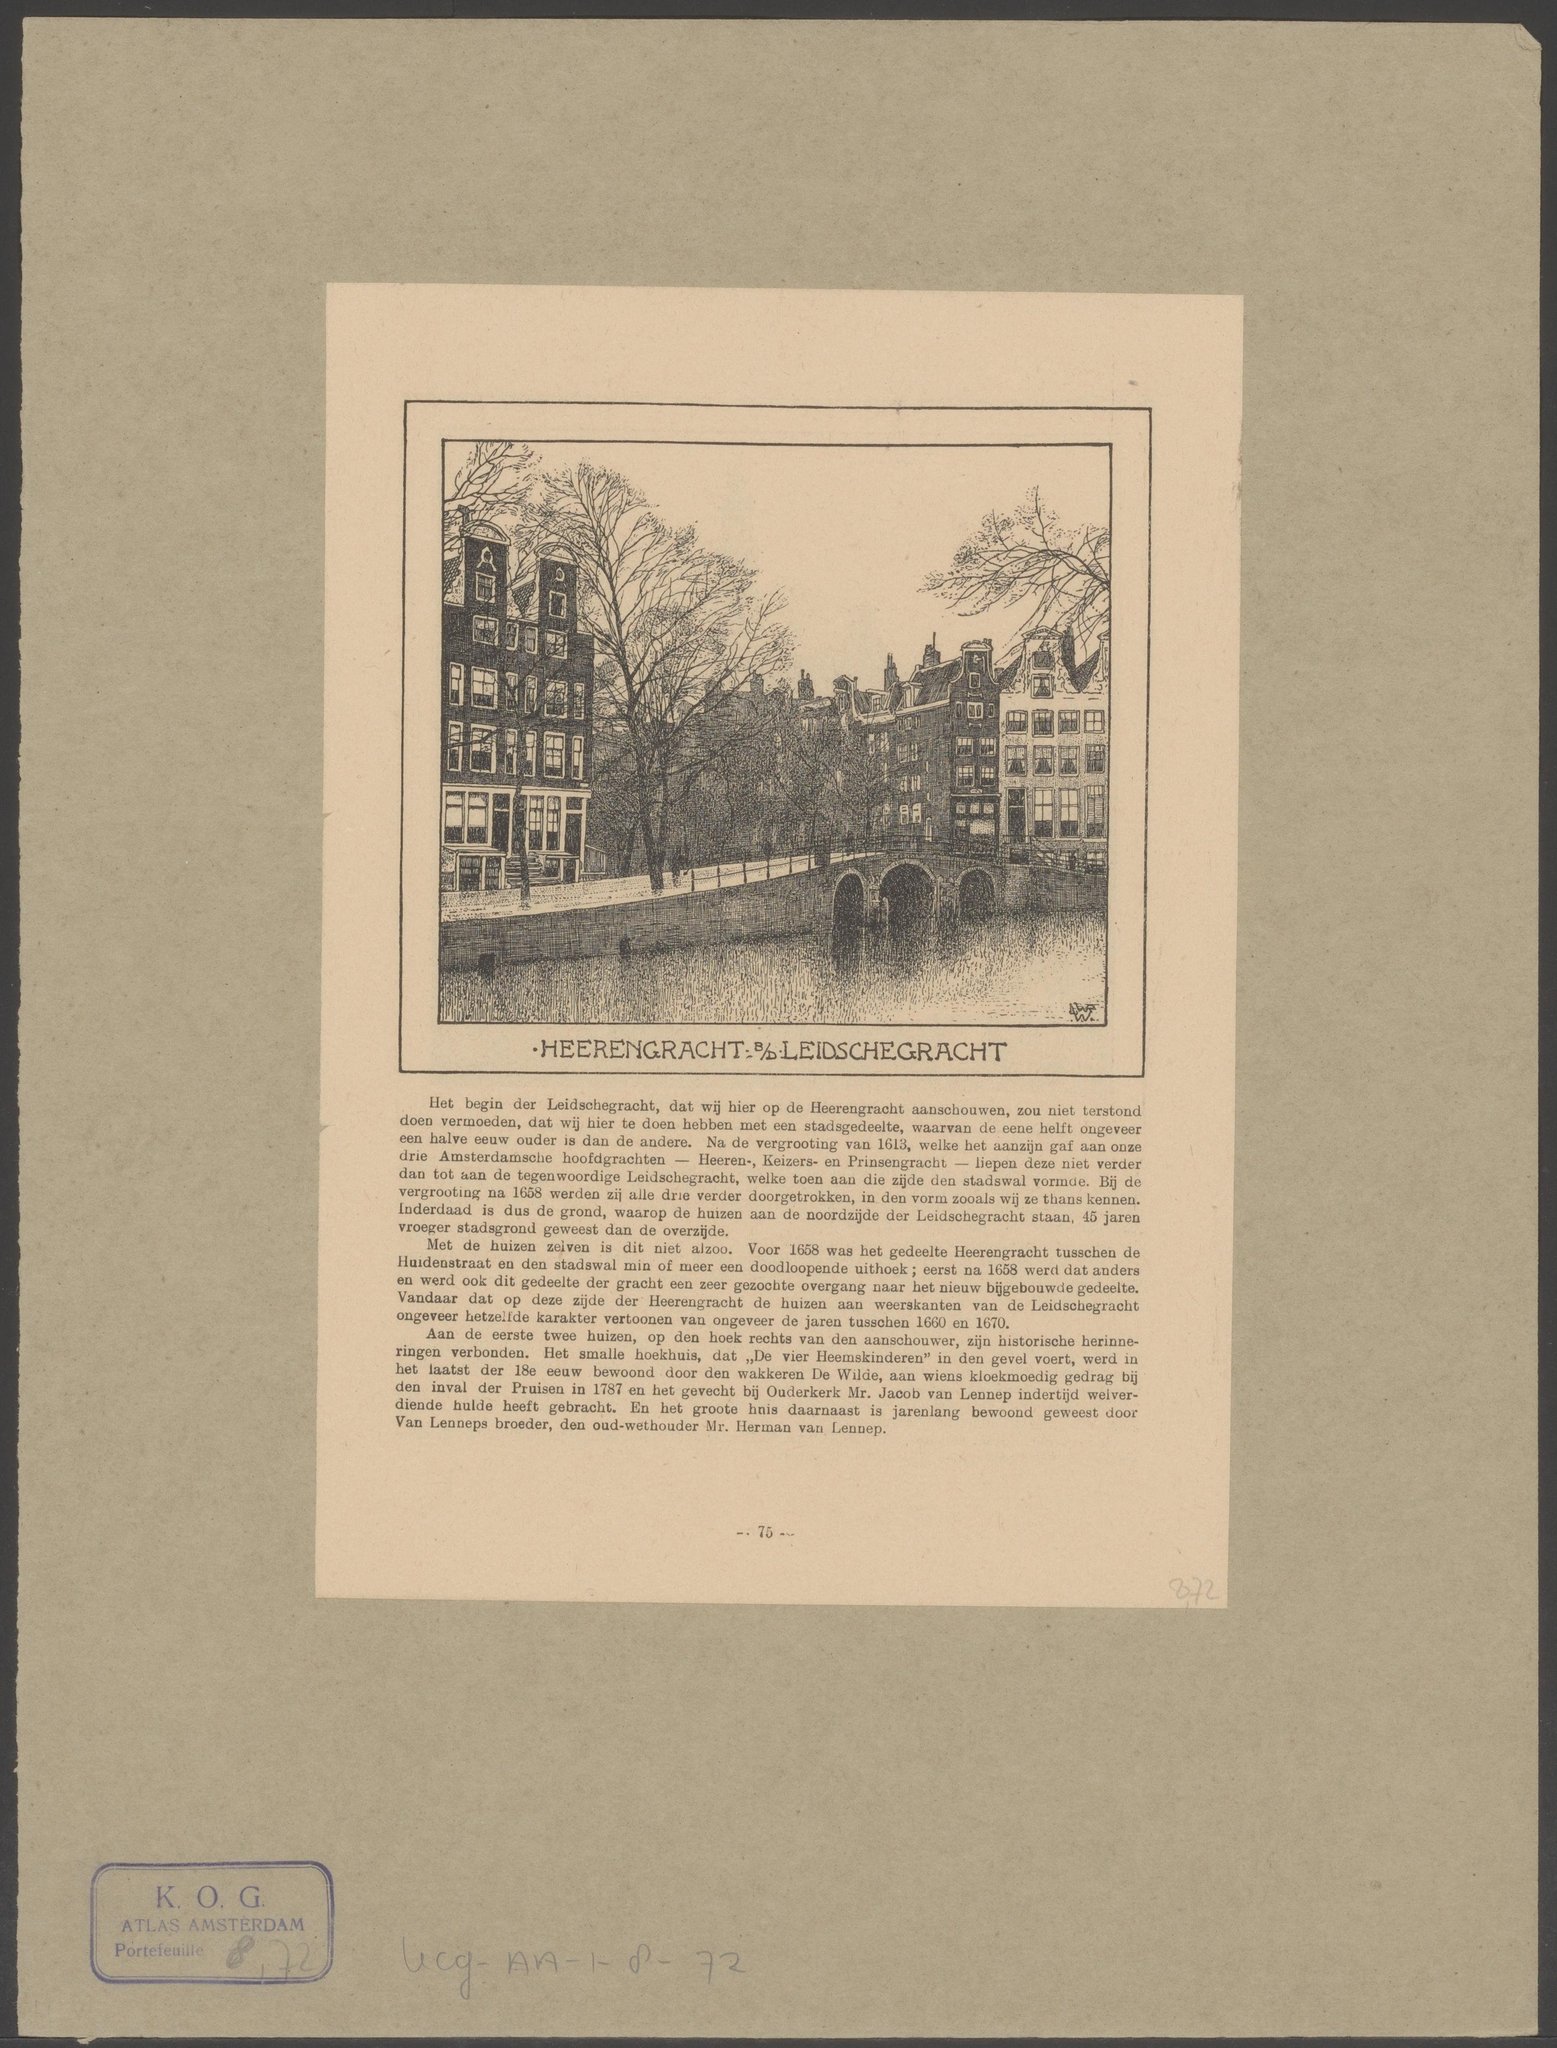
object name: photomechanical print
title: Gezicht op de Herengracht bij de Leidsegracht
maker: willem wenckebach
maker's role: designer, draughtsman, painter, print maker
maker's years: 1860-1937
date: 1870-1923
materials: paper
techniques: letterpress printing, line block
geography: amsterdam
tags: city-view in general; 'veduta', canal, the usual house or row of houses, bridge in city across river, canal, etc.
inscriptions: collector's mark: ‘8,72’ Lugt 1641b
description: Onderwerpsrubriek binnen de Atlas Amsterdam: Haarlemmerplein, Halvemaansteeg, Handboogstraat, Handelskade, Haringpakkerij, Hartenstraat, Hasseltsteeg (Dirk van), Heerengracht.